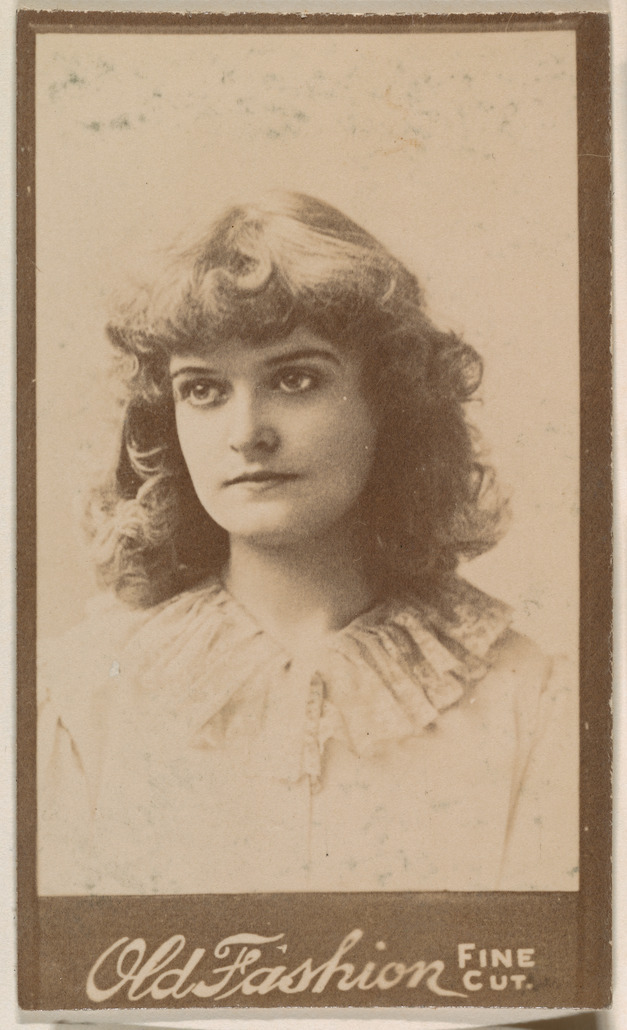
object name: photograph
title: Portrait of actress, from the Actresses series (N664) promoting Old Fashion Fine Cut Tobacco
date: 1888-1890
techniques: albumen silver print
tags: portraits,women,actresses